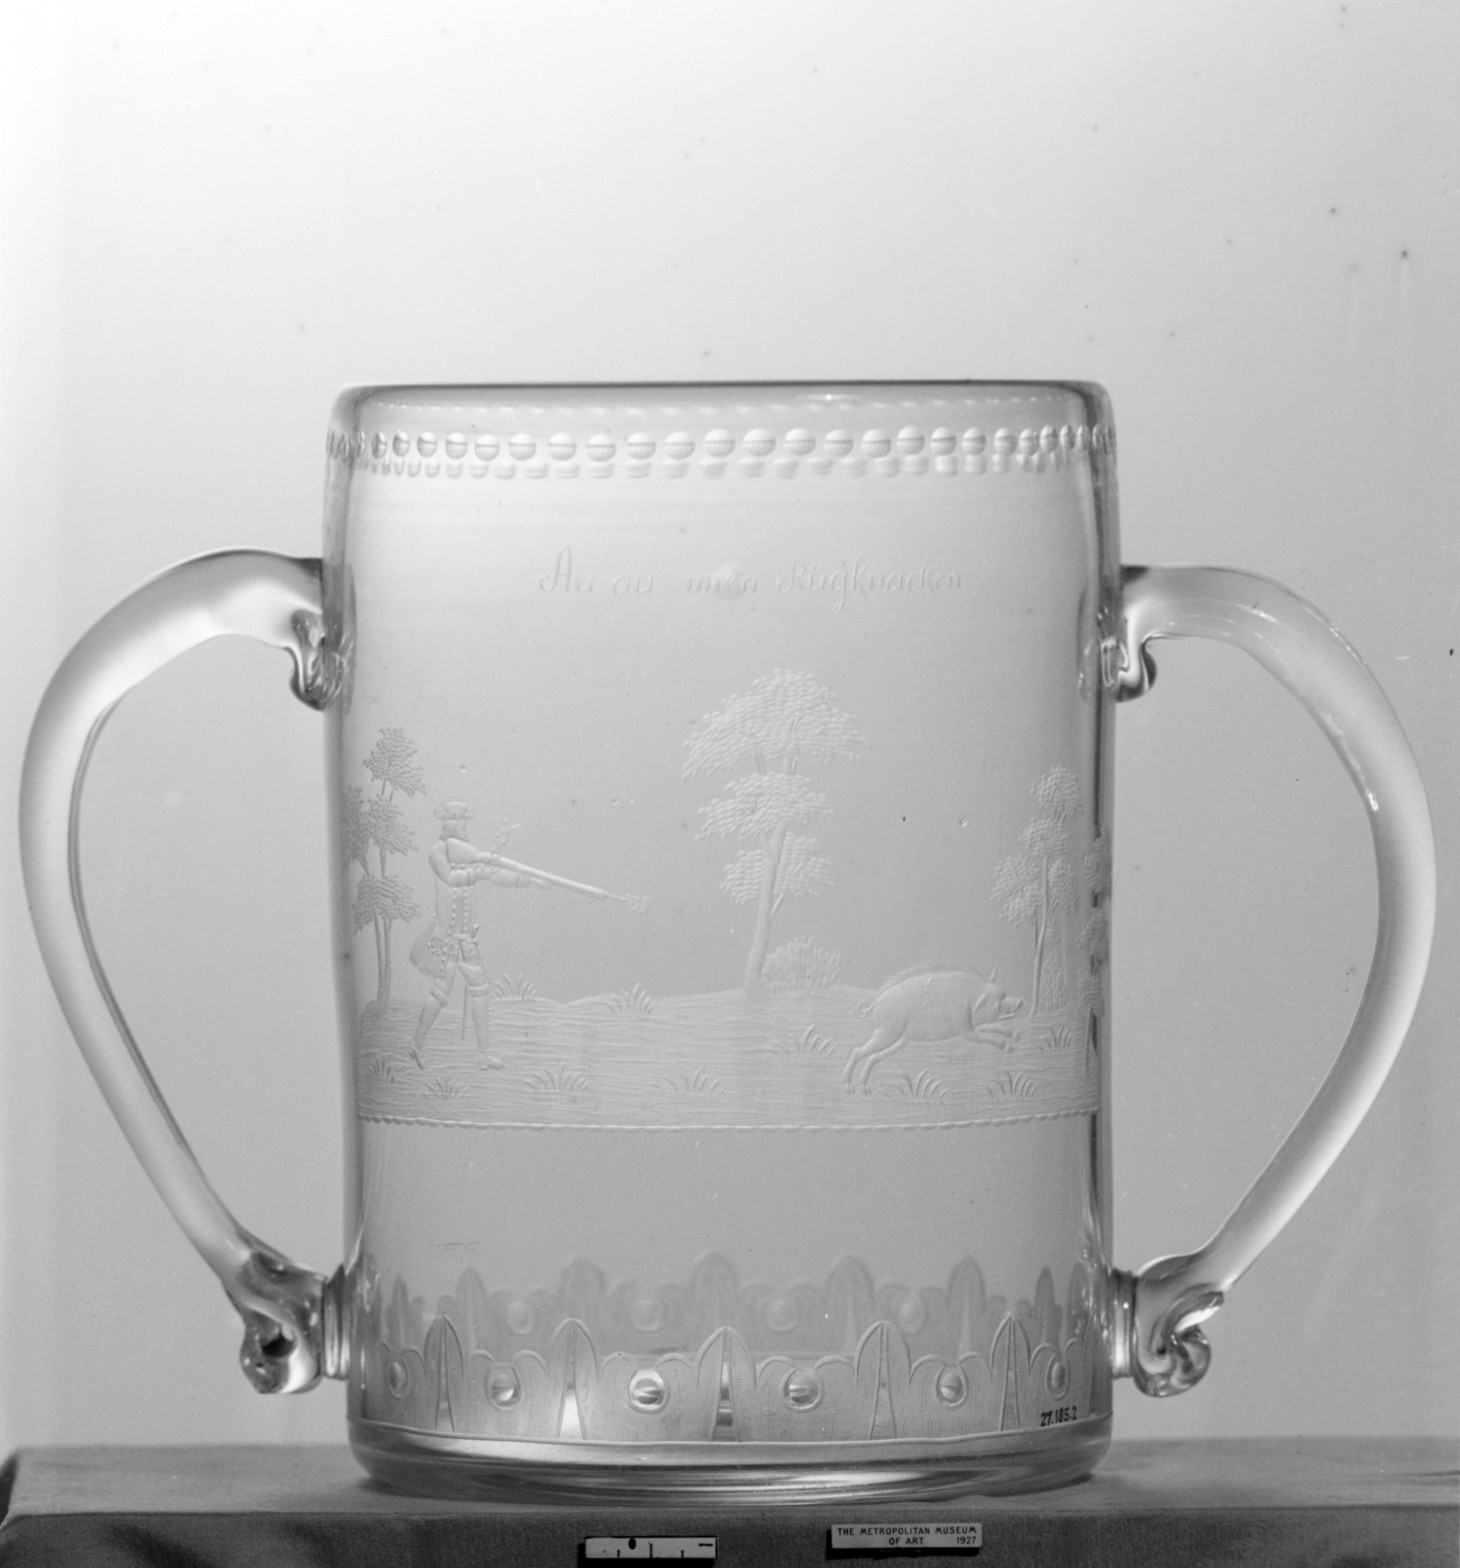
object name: cup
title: Two-handled cup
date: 1720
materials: glass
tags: firearms,hunting,pigs